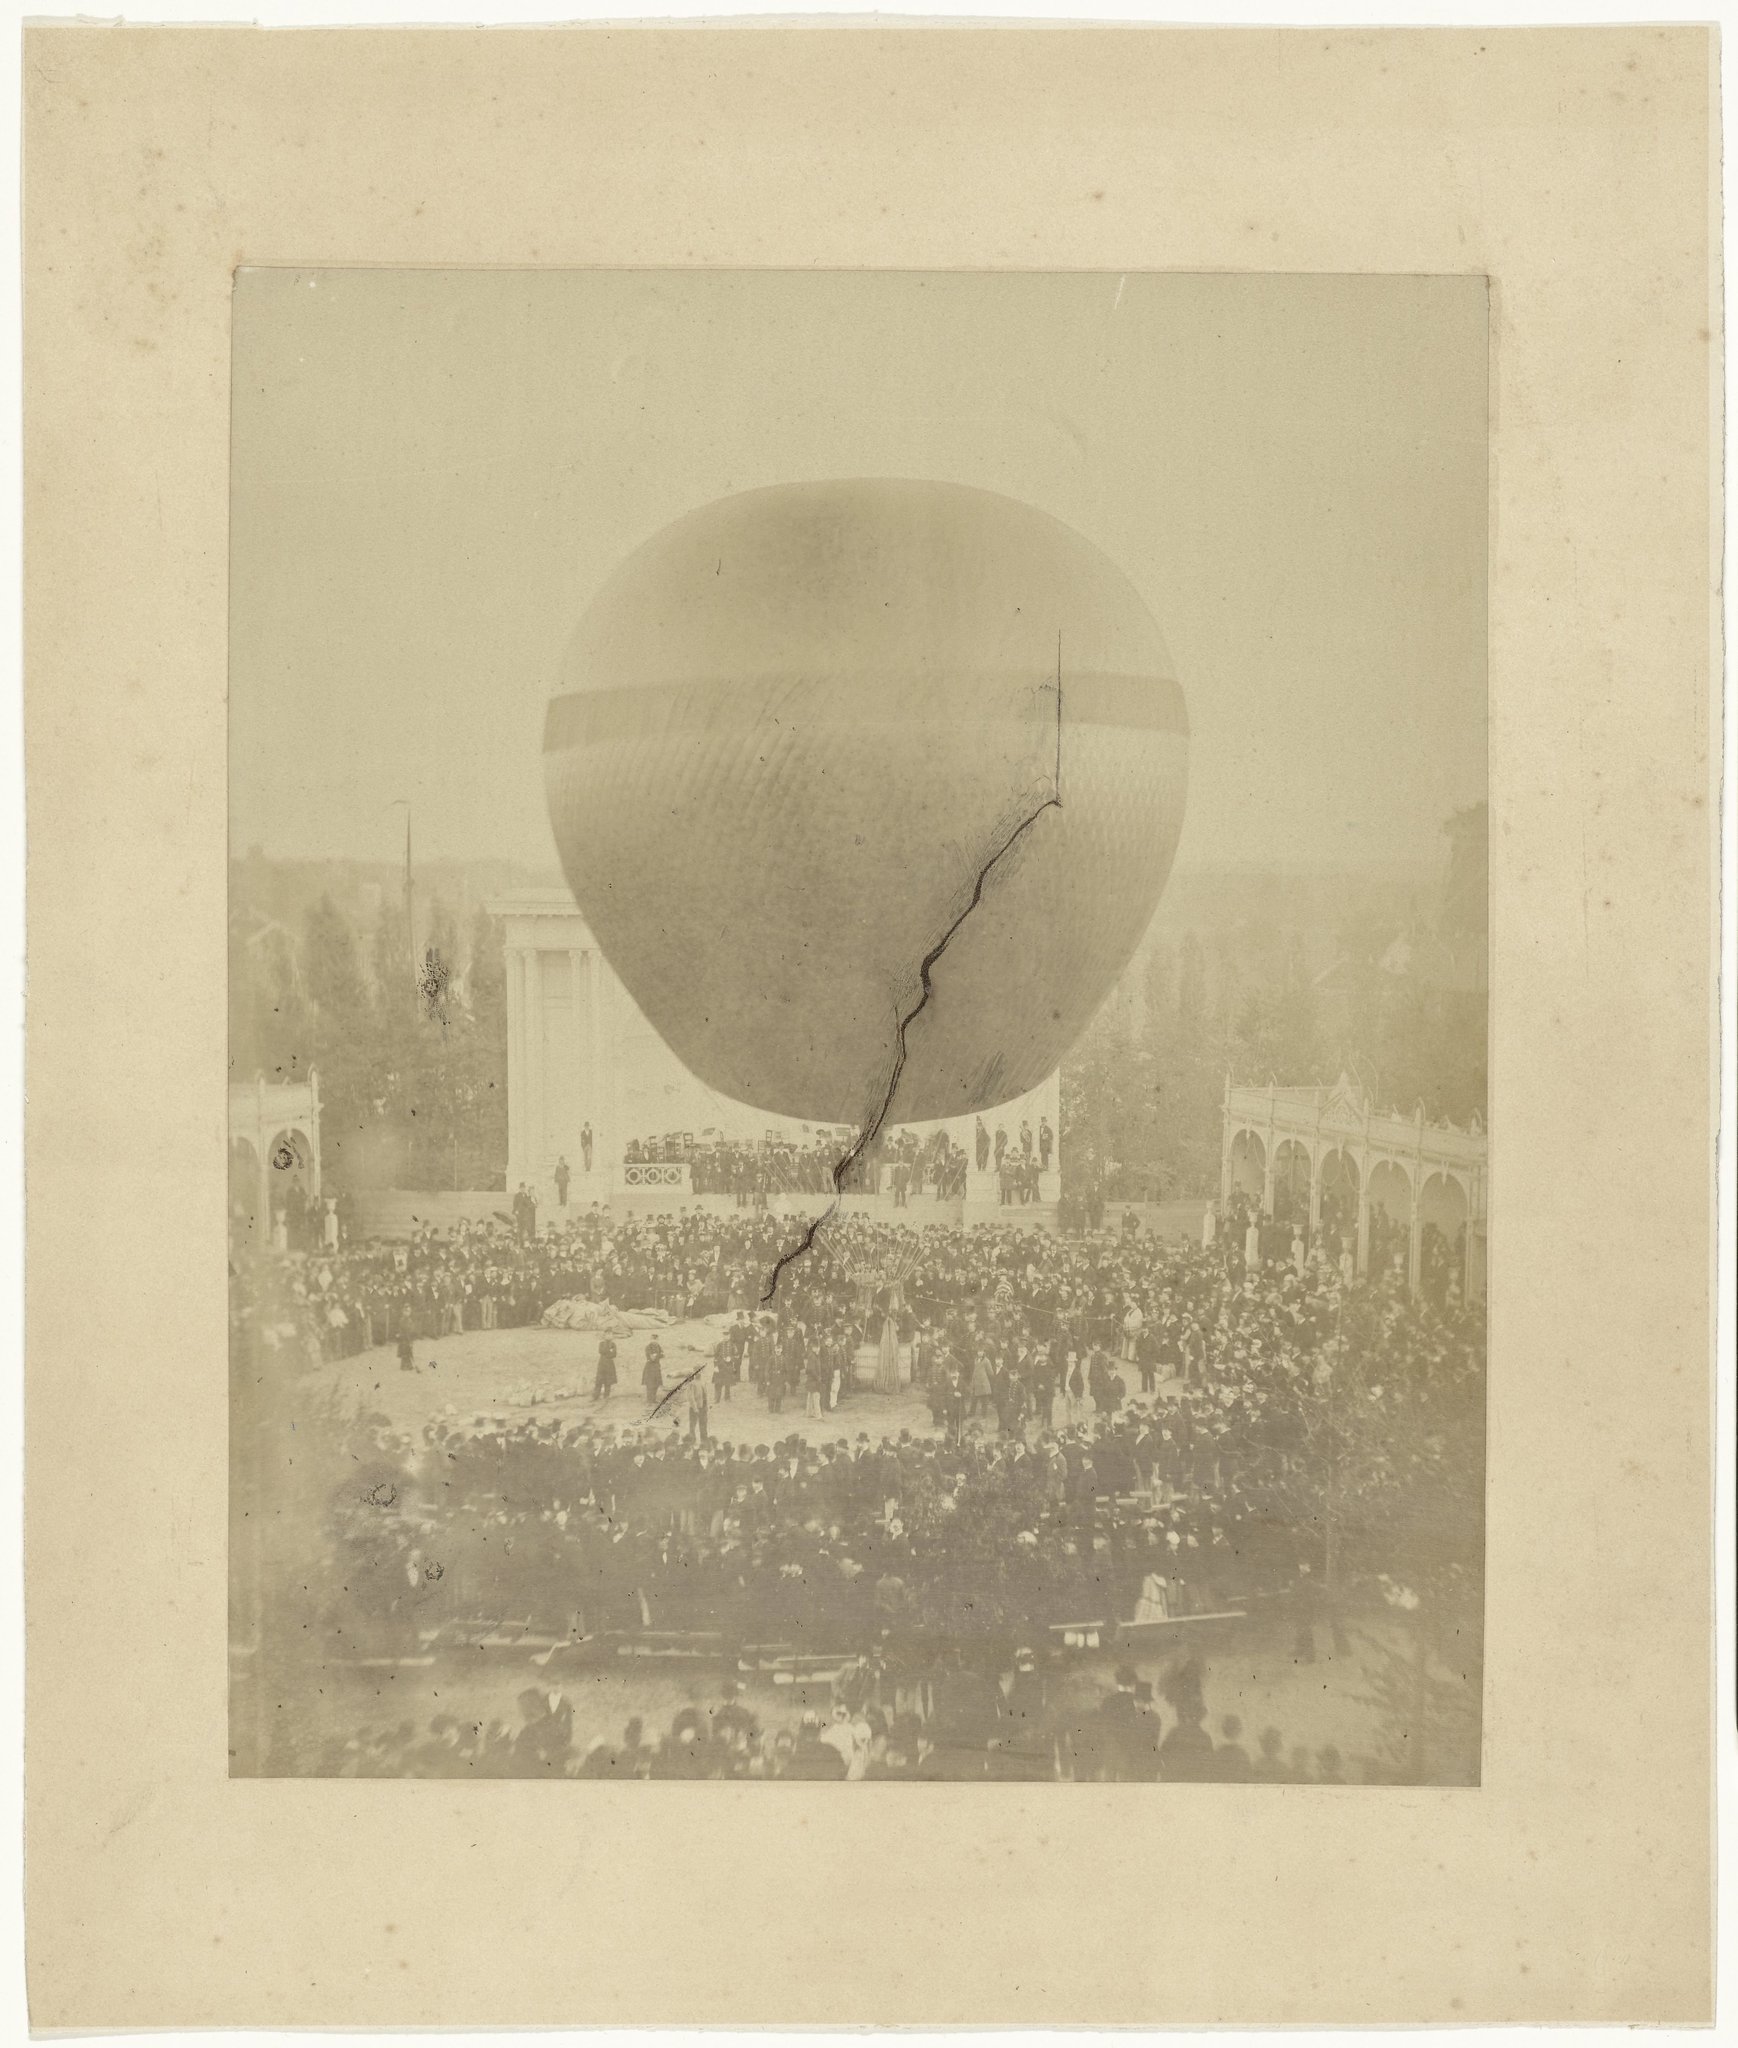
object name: photograph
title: De ballon Le Météore van Eugène Godard in de tuin achter het Paleis voor Volksvlijt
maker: jacques pilartz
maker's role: fotograaf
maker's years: 1834-1910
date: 1874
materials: paper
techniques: albumen print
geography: amsterdam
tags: (flying a) gas balloon, amsterdam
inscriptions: title: ‘Luchtballon van Nadar. o/h Frederiksplein. (NB. een vlucht Nahan was in 1858, eerste vlucht met de geant 1864)’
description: Op het midden van de foto is een pen lijn zichtbaar, mogelijk een breuk in het negatief, geprobeerd te retoucheren op de foto met inkt.